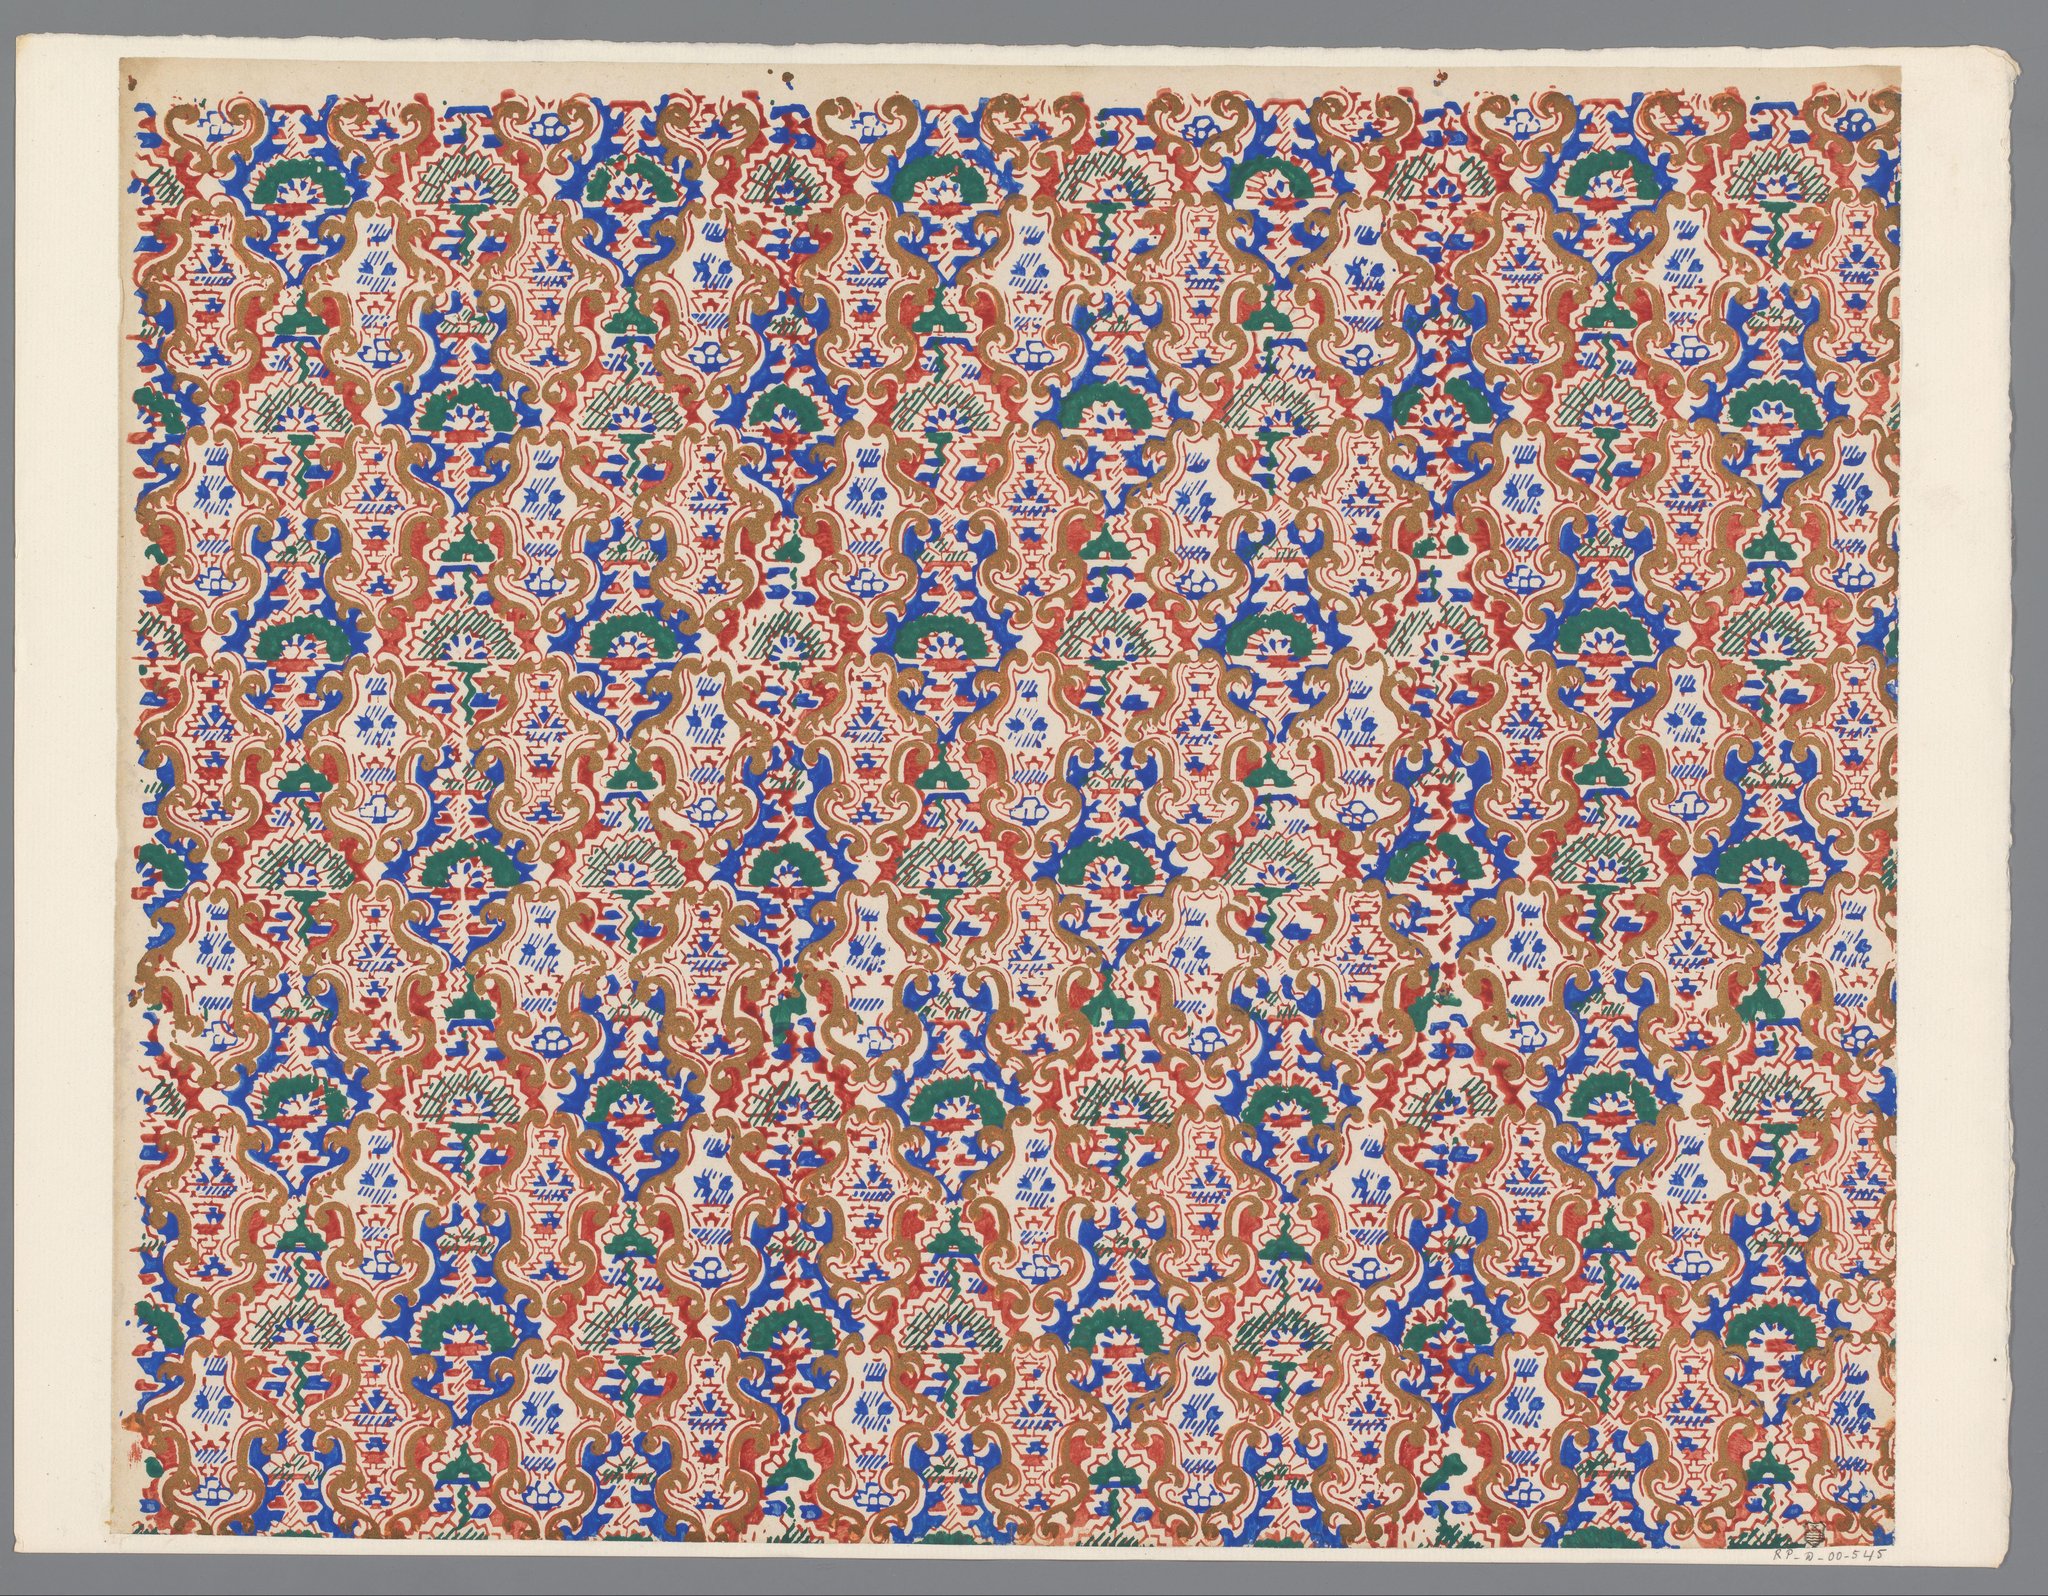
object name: printed paper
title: Blad met accoladepatroon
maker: Anonymous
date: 1800-1900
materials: paint, paper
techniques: printing block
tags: fantasy ornament, ornament ~ geometric motifs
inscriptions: collector's mark: Lugt 2760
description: Blad met accoladepatroon en geometrische vlakvulling.